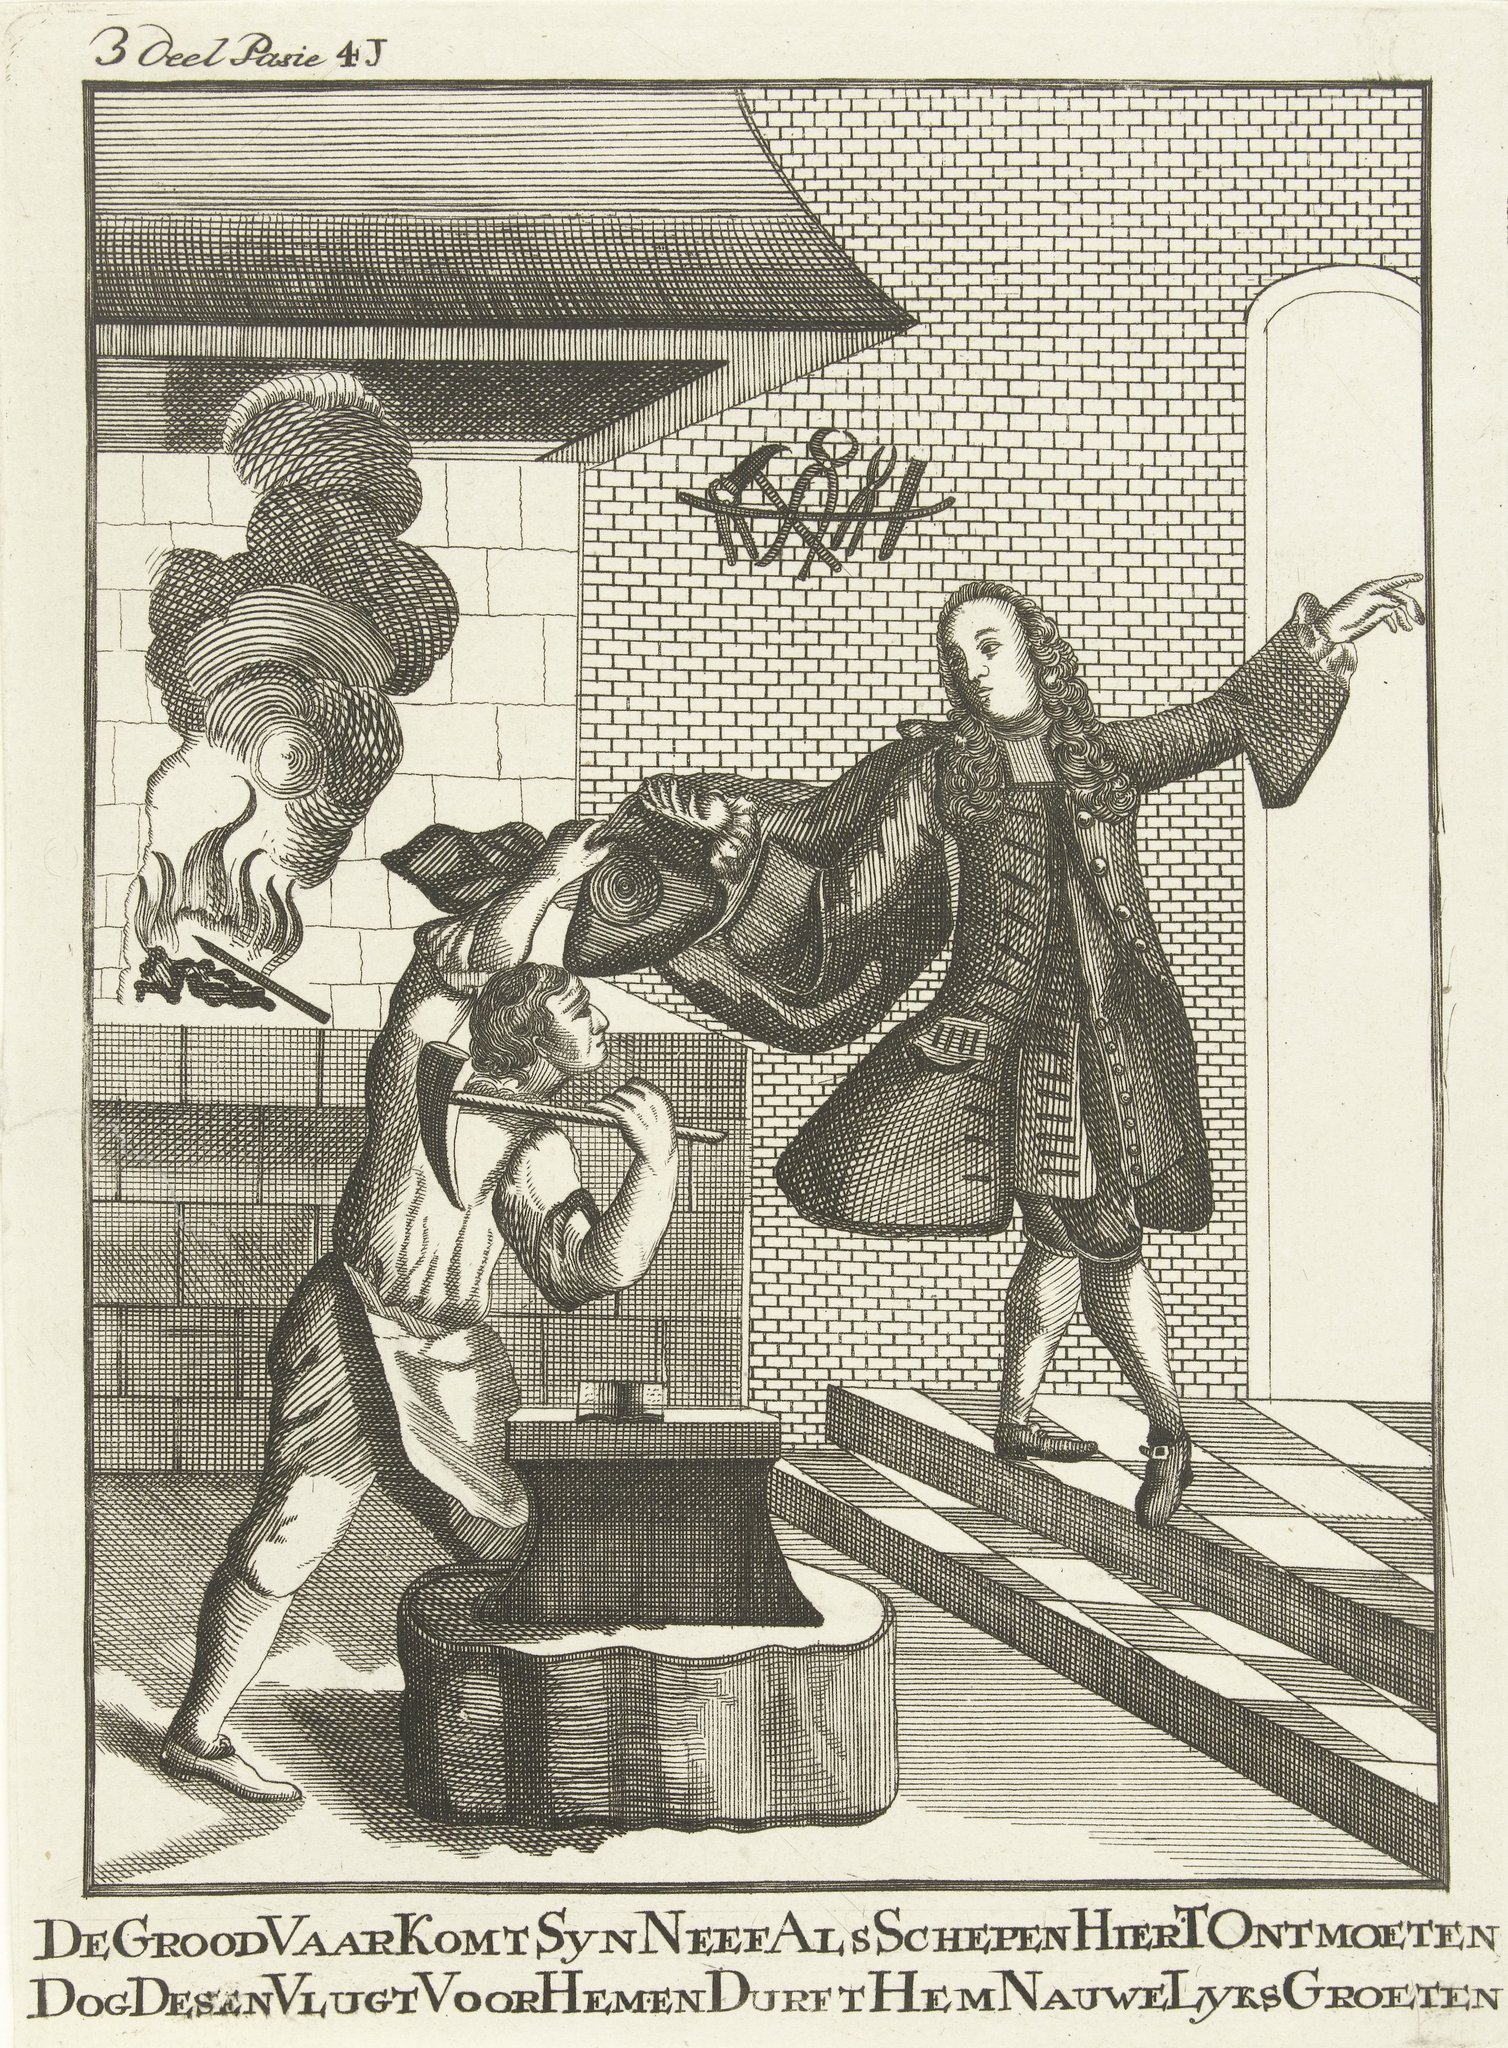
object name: cartoon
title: De Grood Vaar Komt Syn Neef Als Schepen Hier T Ontmoeten / Dog Desen Vlugt Voor Hem en Durft Hem NauweLyks Groeten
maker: Anonymous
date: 1749-1751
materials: paper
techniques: engraving, etching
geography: northern netherlands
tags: smith, blacksmith, amsterdam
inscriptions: collector's mark: Lugt 2228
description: Spotprent op de Amsterdamse schepen Jasper Bolten die zijn grootvader die vroeger smidsknecht was ontloopt en niet wil ontmoeten, 1751. Gezicht in een smederij met een smid bij het aambeeld en een deftige heer die vlucht naar de deur. Gemerkt linksboven: 3 deel Pagie 4J.